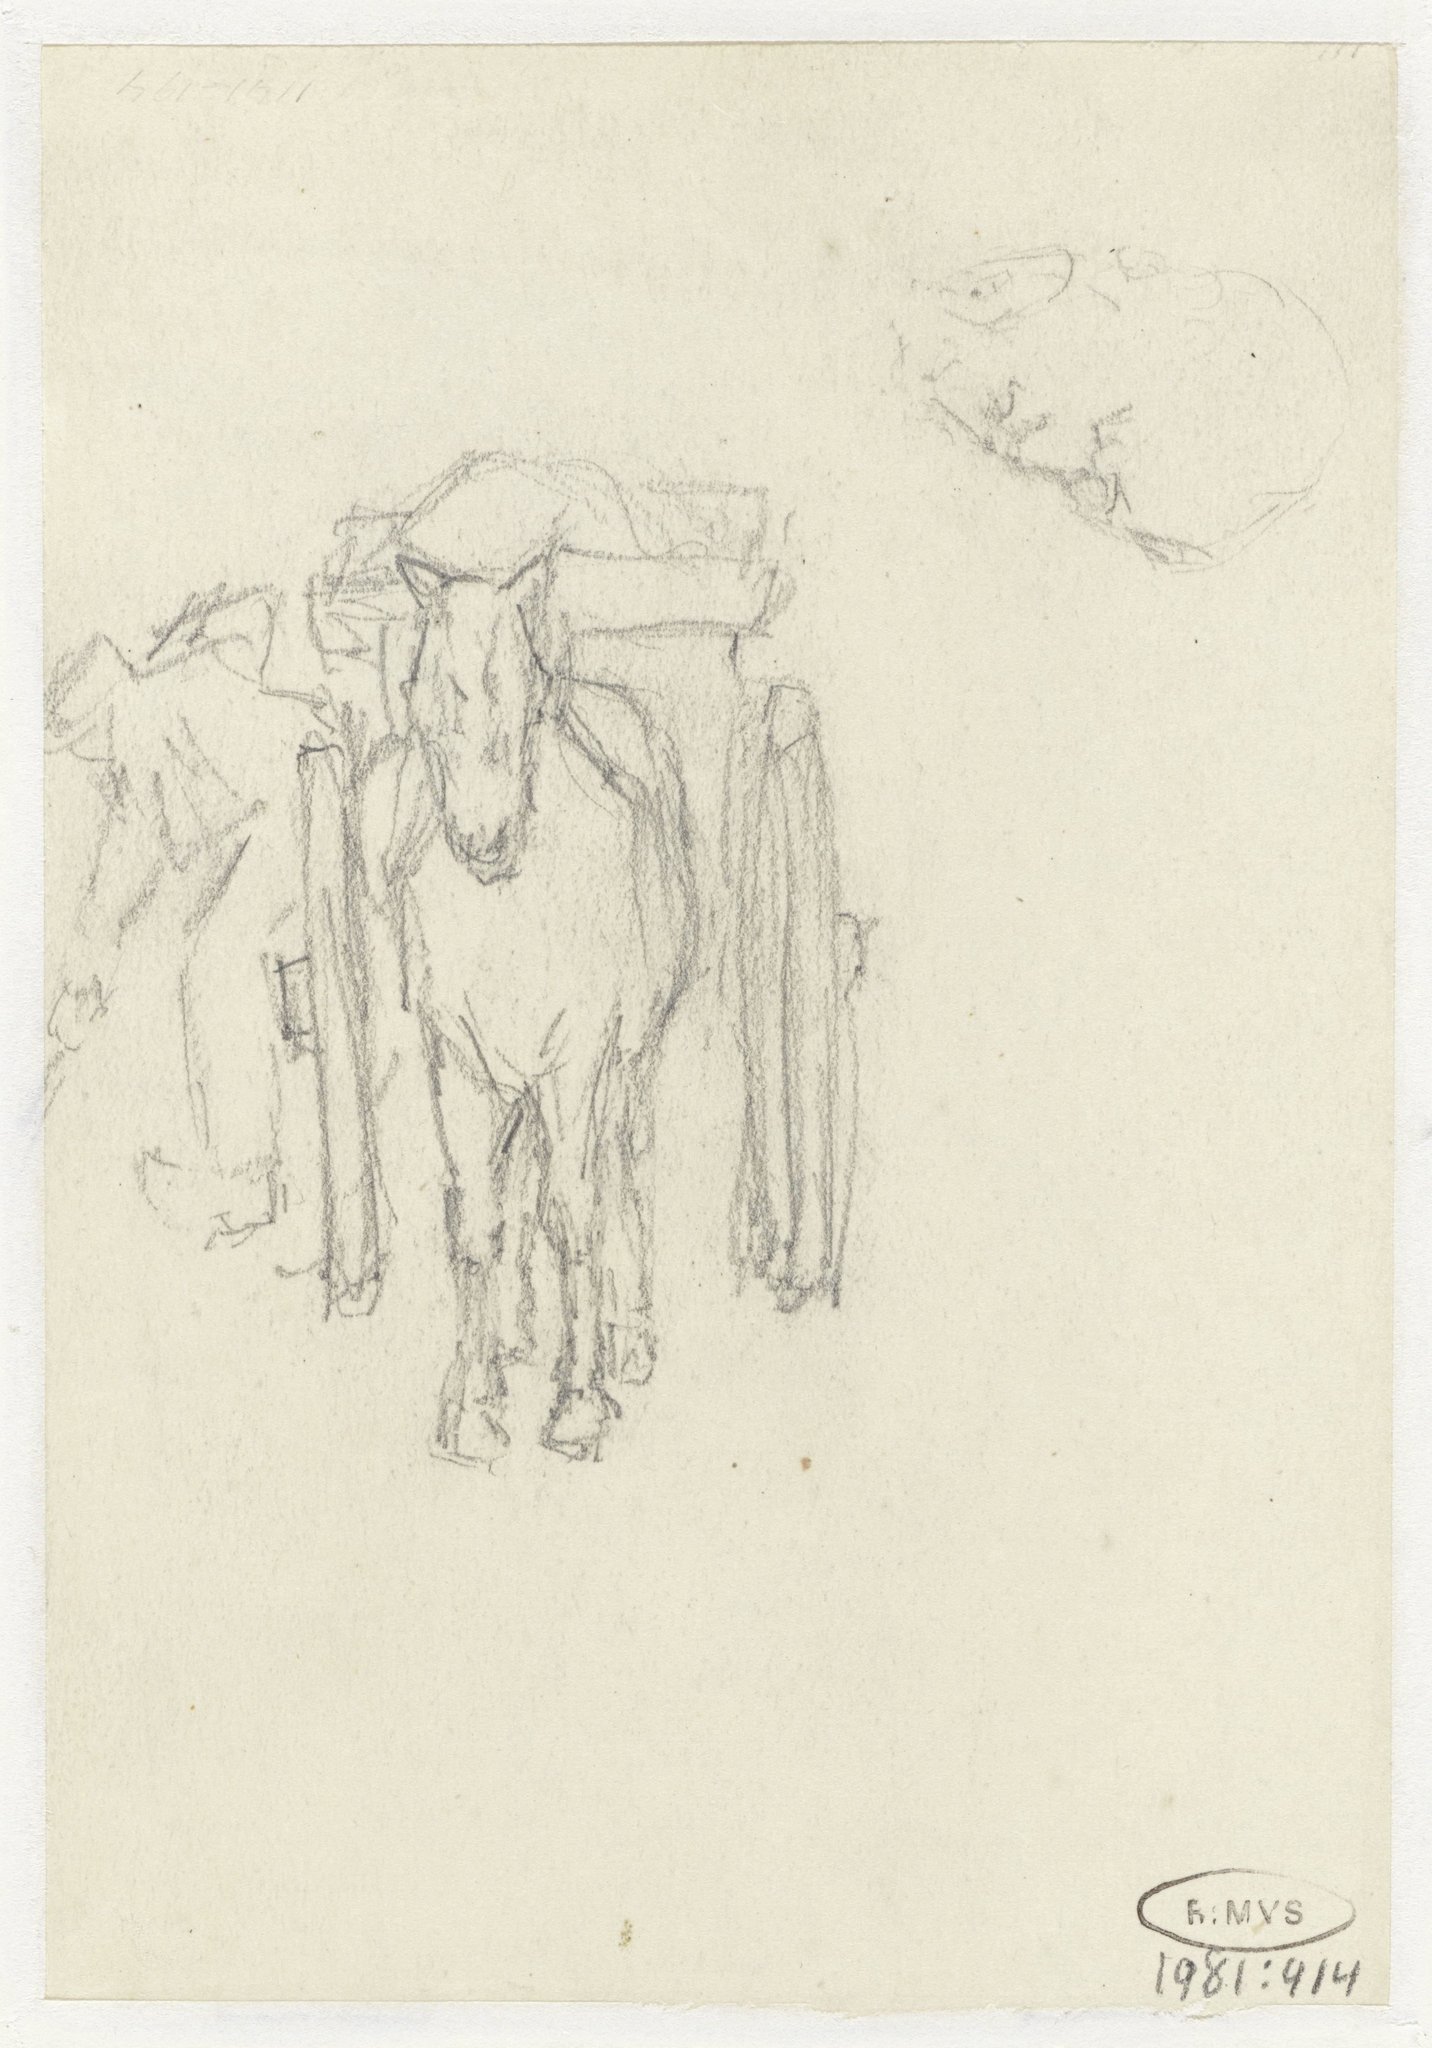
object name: drawing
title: Paard met kar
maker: jozef israëls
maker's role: draughtsman, painter, print maker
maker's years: 1824-1911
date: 1834-1911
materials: paper, pencil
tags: (farm) wagon, freight wagon, cart